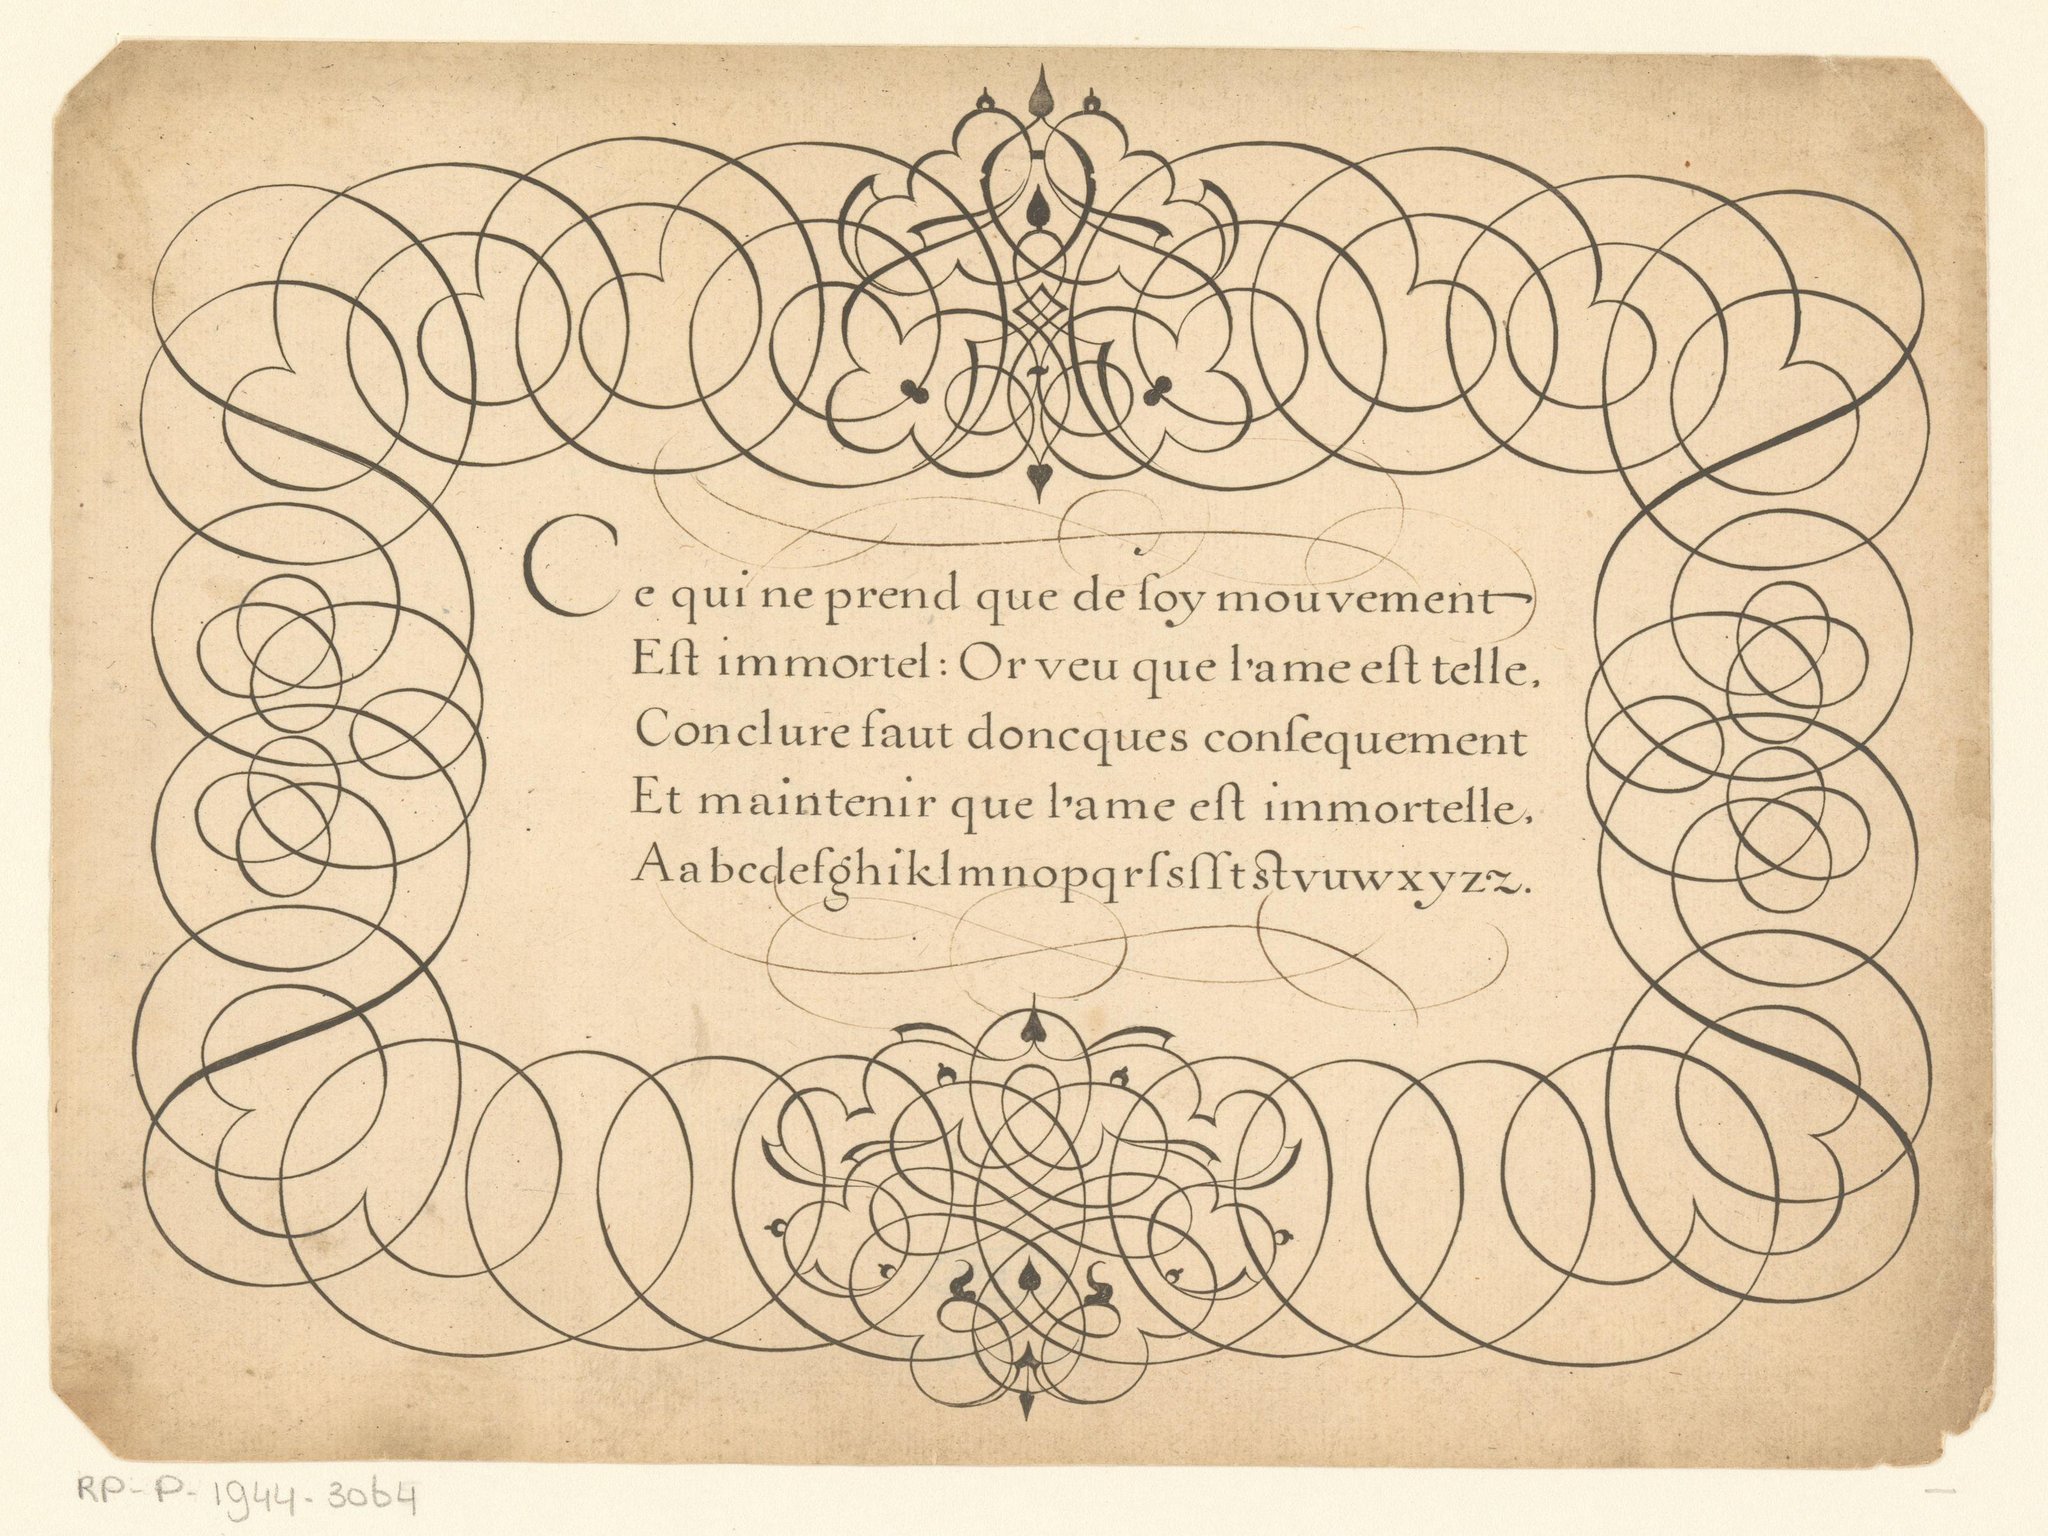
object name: print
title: Schrijfvoorbeeld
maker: Anonymous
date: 1575-1625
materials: paper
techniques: engraving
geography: netherlands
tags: calligraphy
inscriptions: watermark, collector's mark: Lugt 2228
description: Prent is onderdeel van een serie van zes. Zie RP-P-1944-3063, -3064, -3065, -3067, -3071 en -3073.